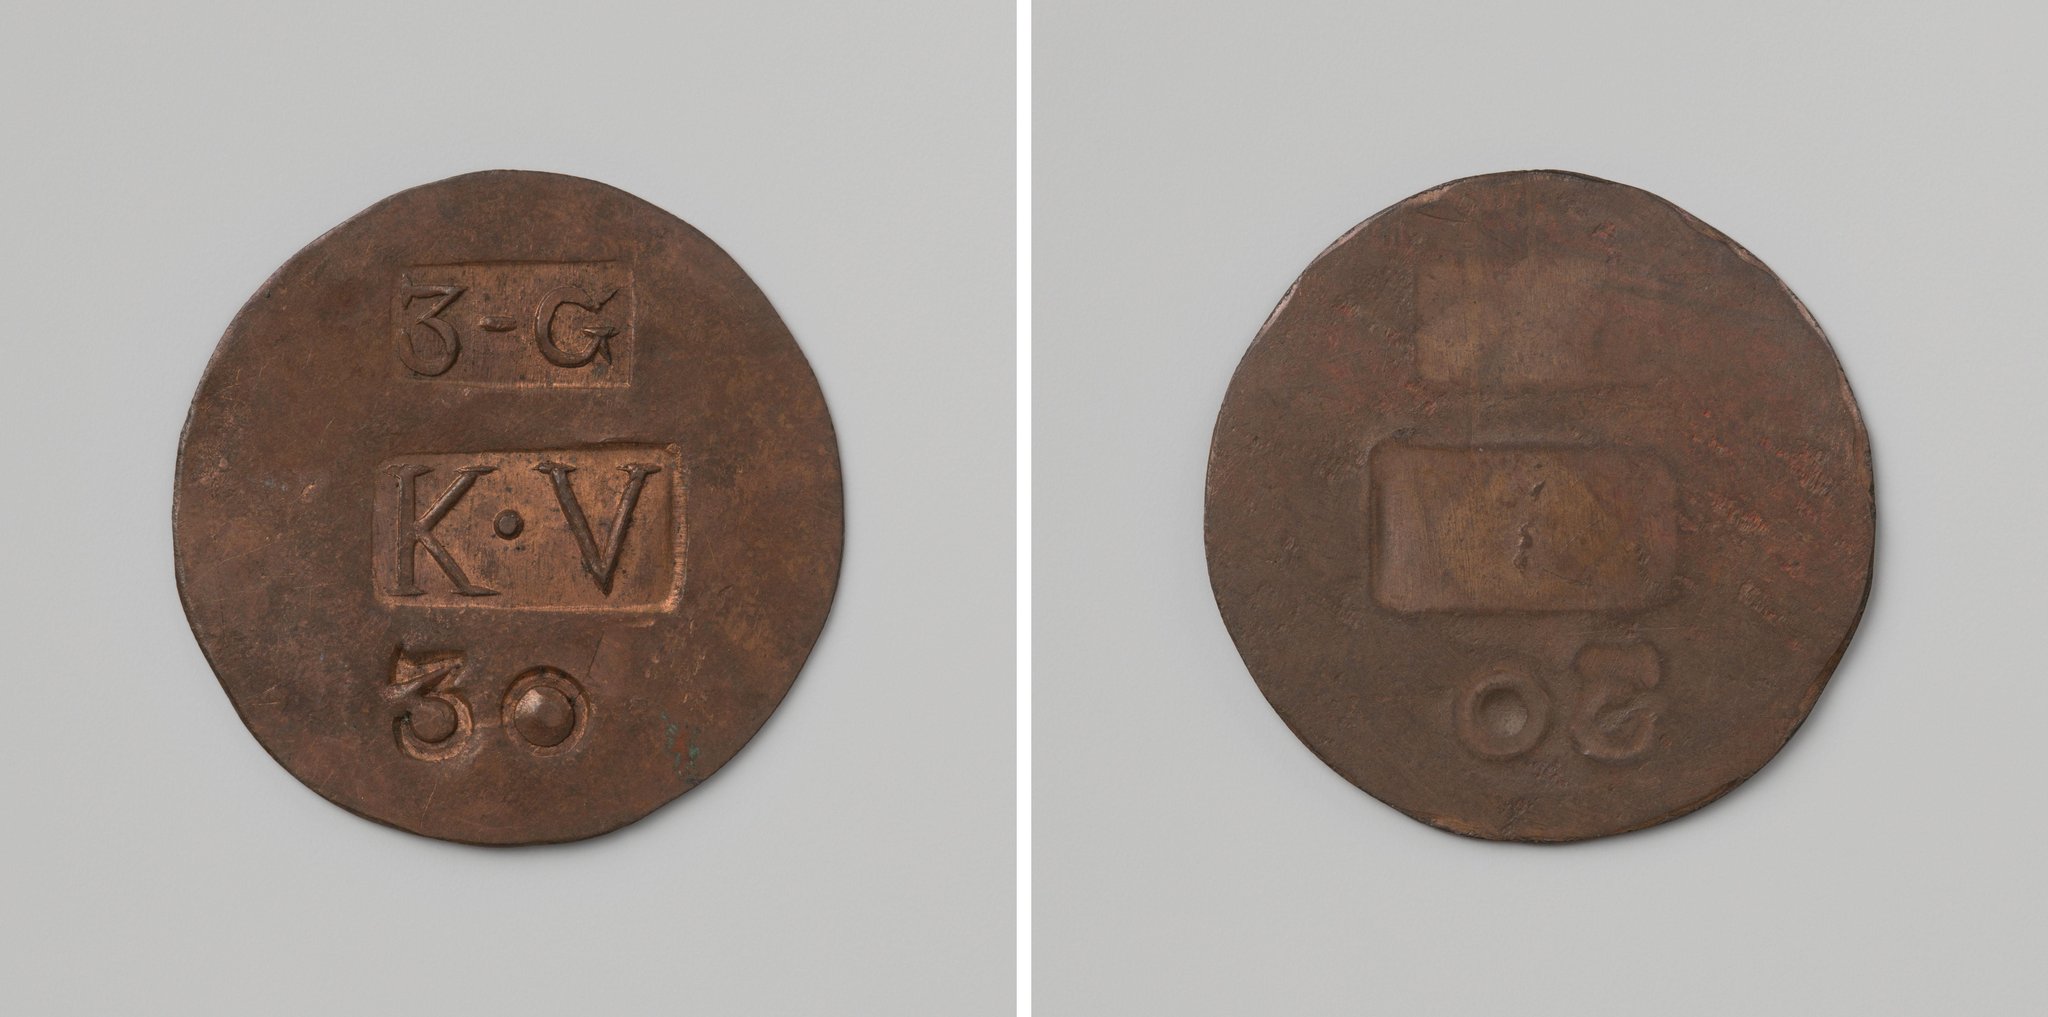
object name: monetary token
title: Derde gesticht van de kolonie Veenhuizen, huismunt geslagen op last van de Maatschappij van Weldadigheid ter waarde van dertig cent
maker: Anonymous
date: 1818-1859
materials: copper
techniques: striking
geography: netherlands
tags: maatschappij van weldadigheid, veenhuizen